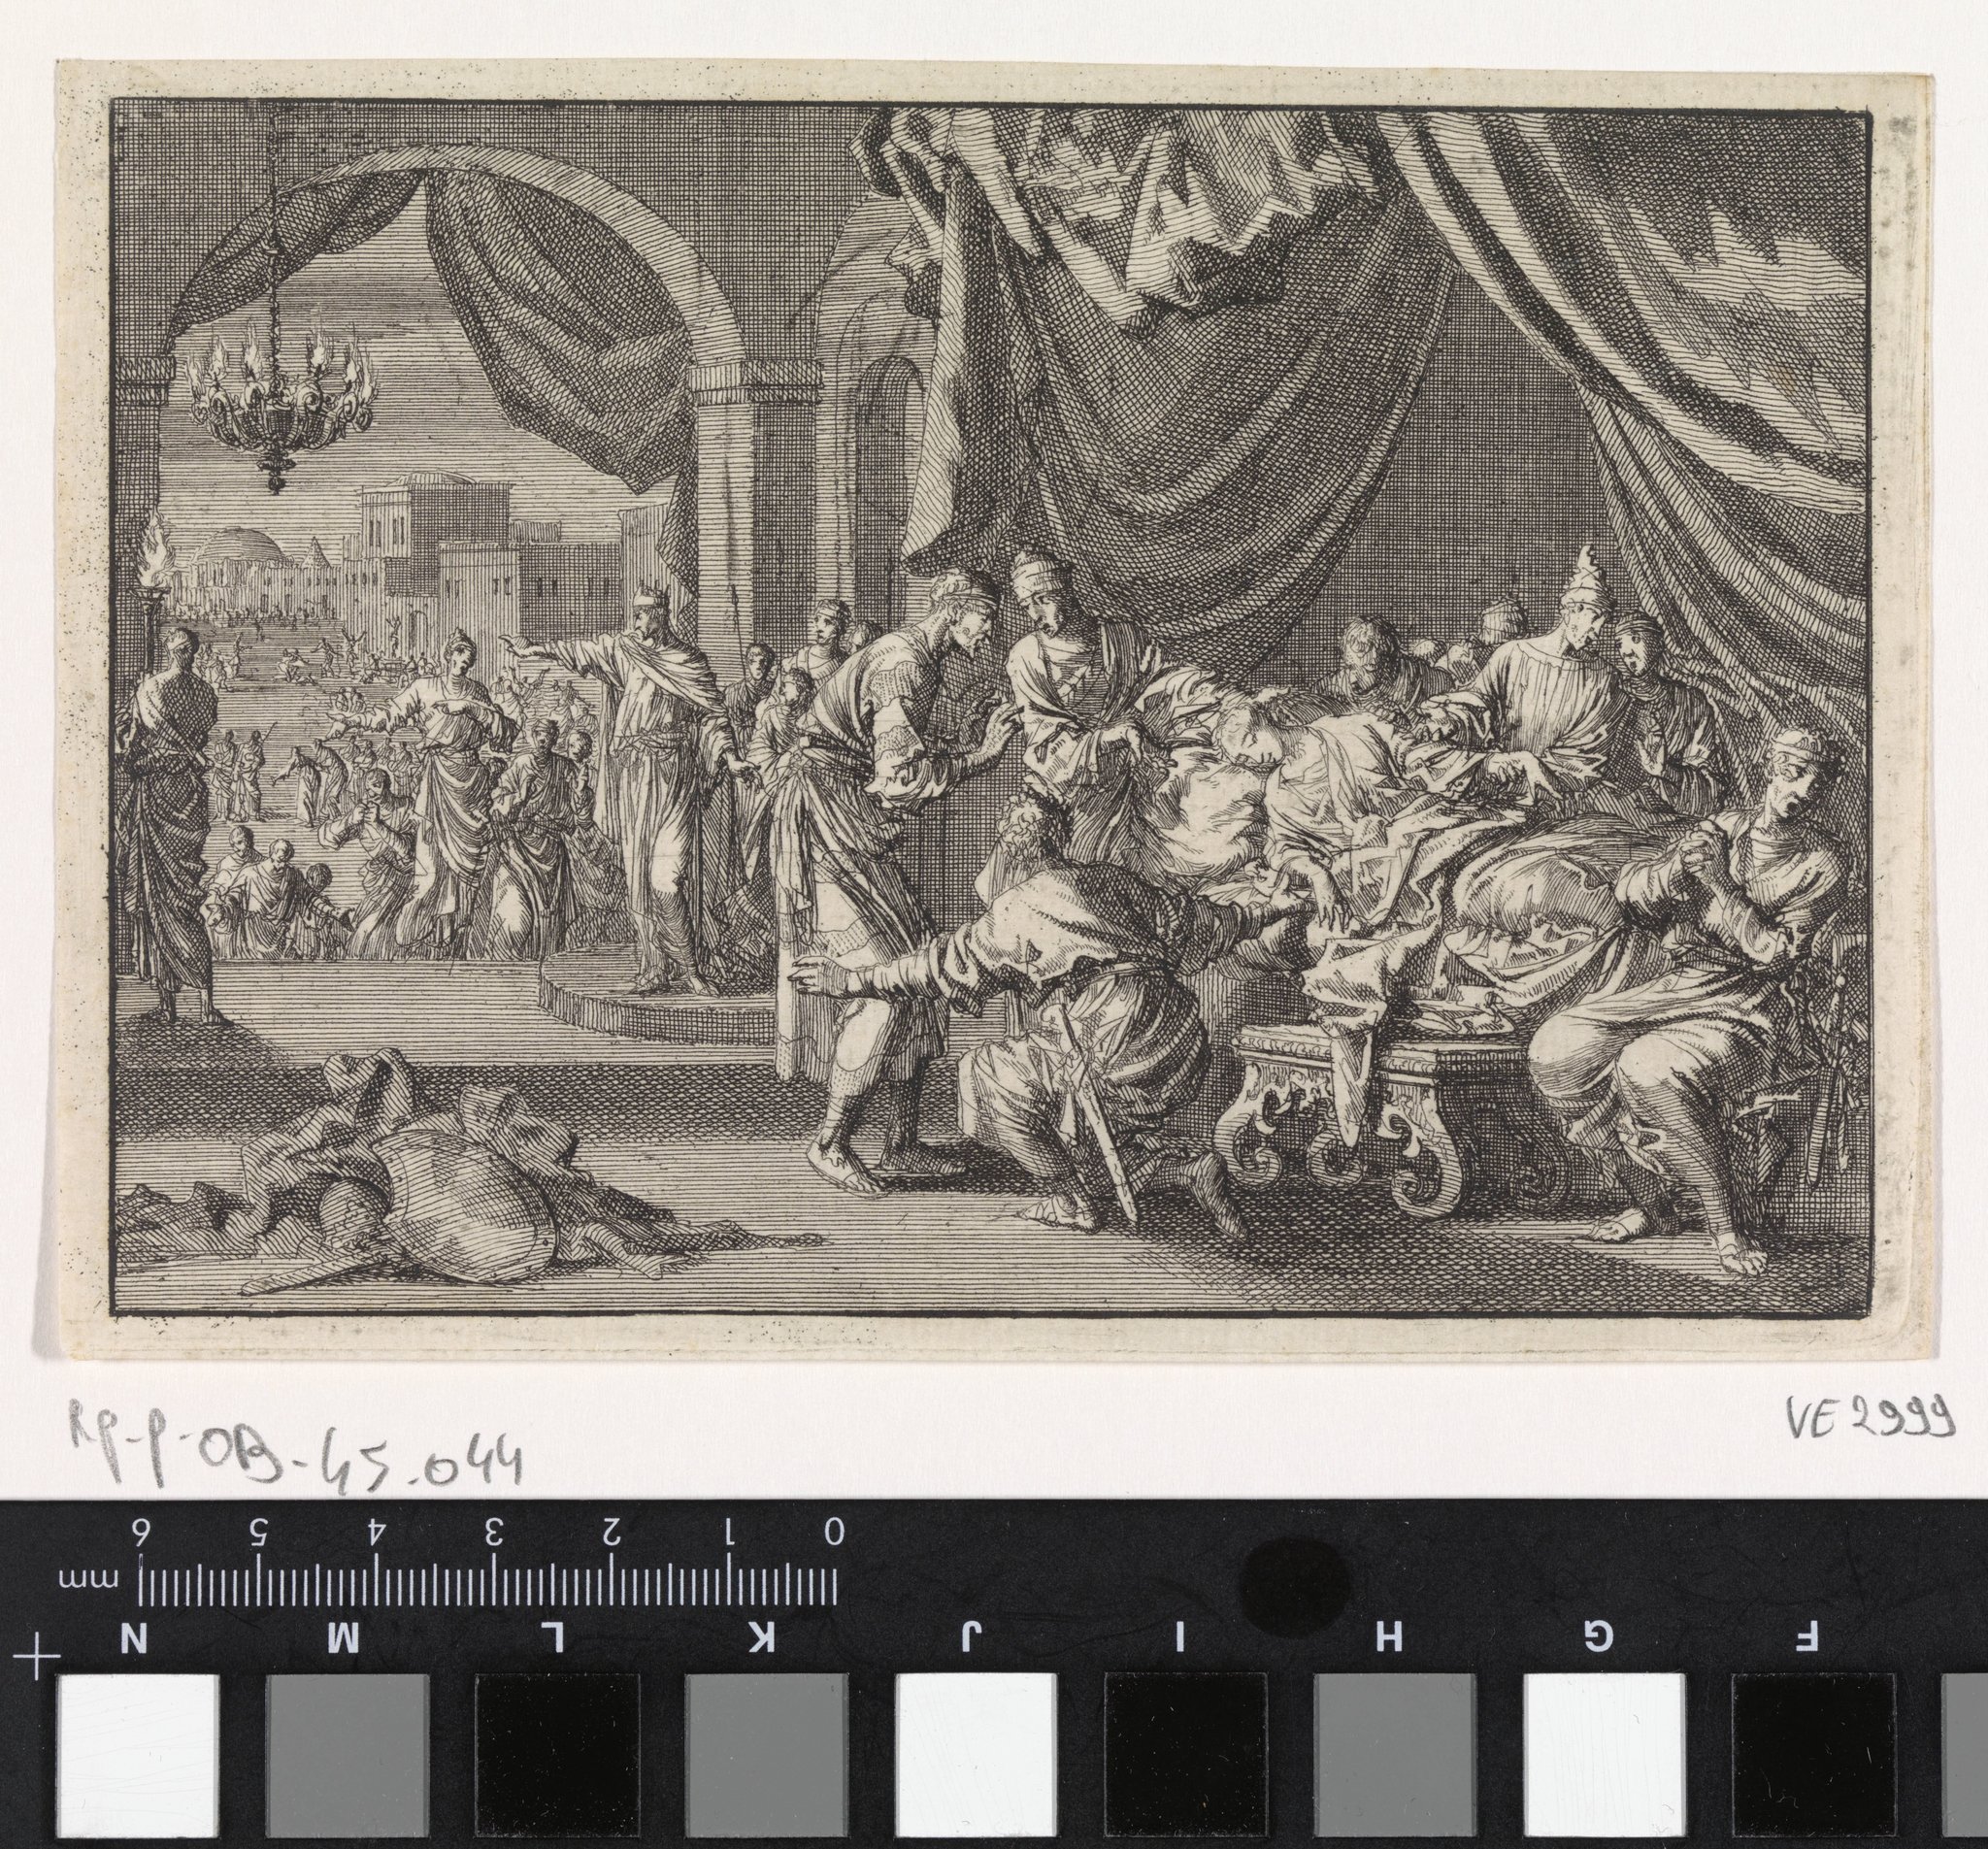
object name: print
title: Dood van de eerstgeborenen in Egypte, waaronder de zoon van de farao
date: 1703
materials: paper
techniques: etching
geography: haarlem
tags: the plague of the first-born: the destroying angel passes through the land and kills every egyptian first-born of man and animal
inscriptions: collector's mark: Lugt 2228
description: Proefdruk van een boekillustratie voor David Martin. Historie des Ouden en Nieuwen Testaments. Amsterdam, Pieter Mortier, 1703. Deel I. De boekillustraties voor de Mortierbijbel hebben verschillende staten en kopieën, waarbij de chronologische volgorde moeilijk te achterhalen valt. Als boekillustraties werden ze bovendien herhaaldelijk opnieuw gebruikt voor andere boekwerken.